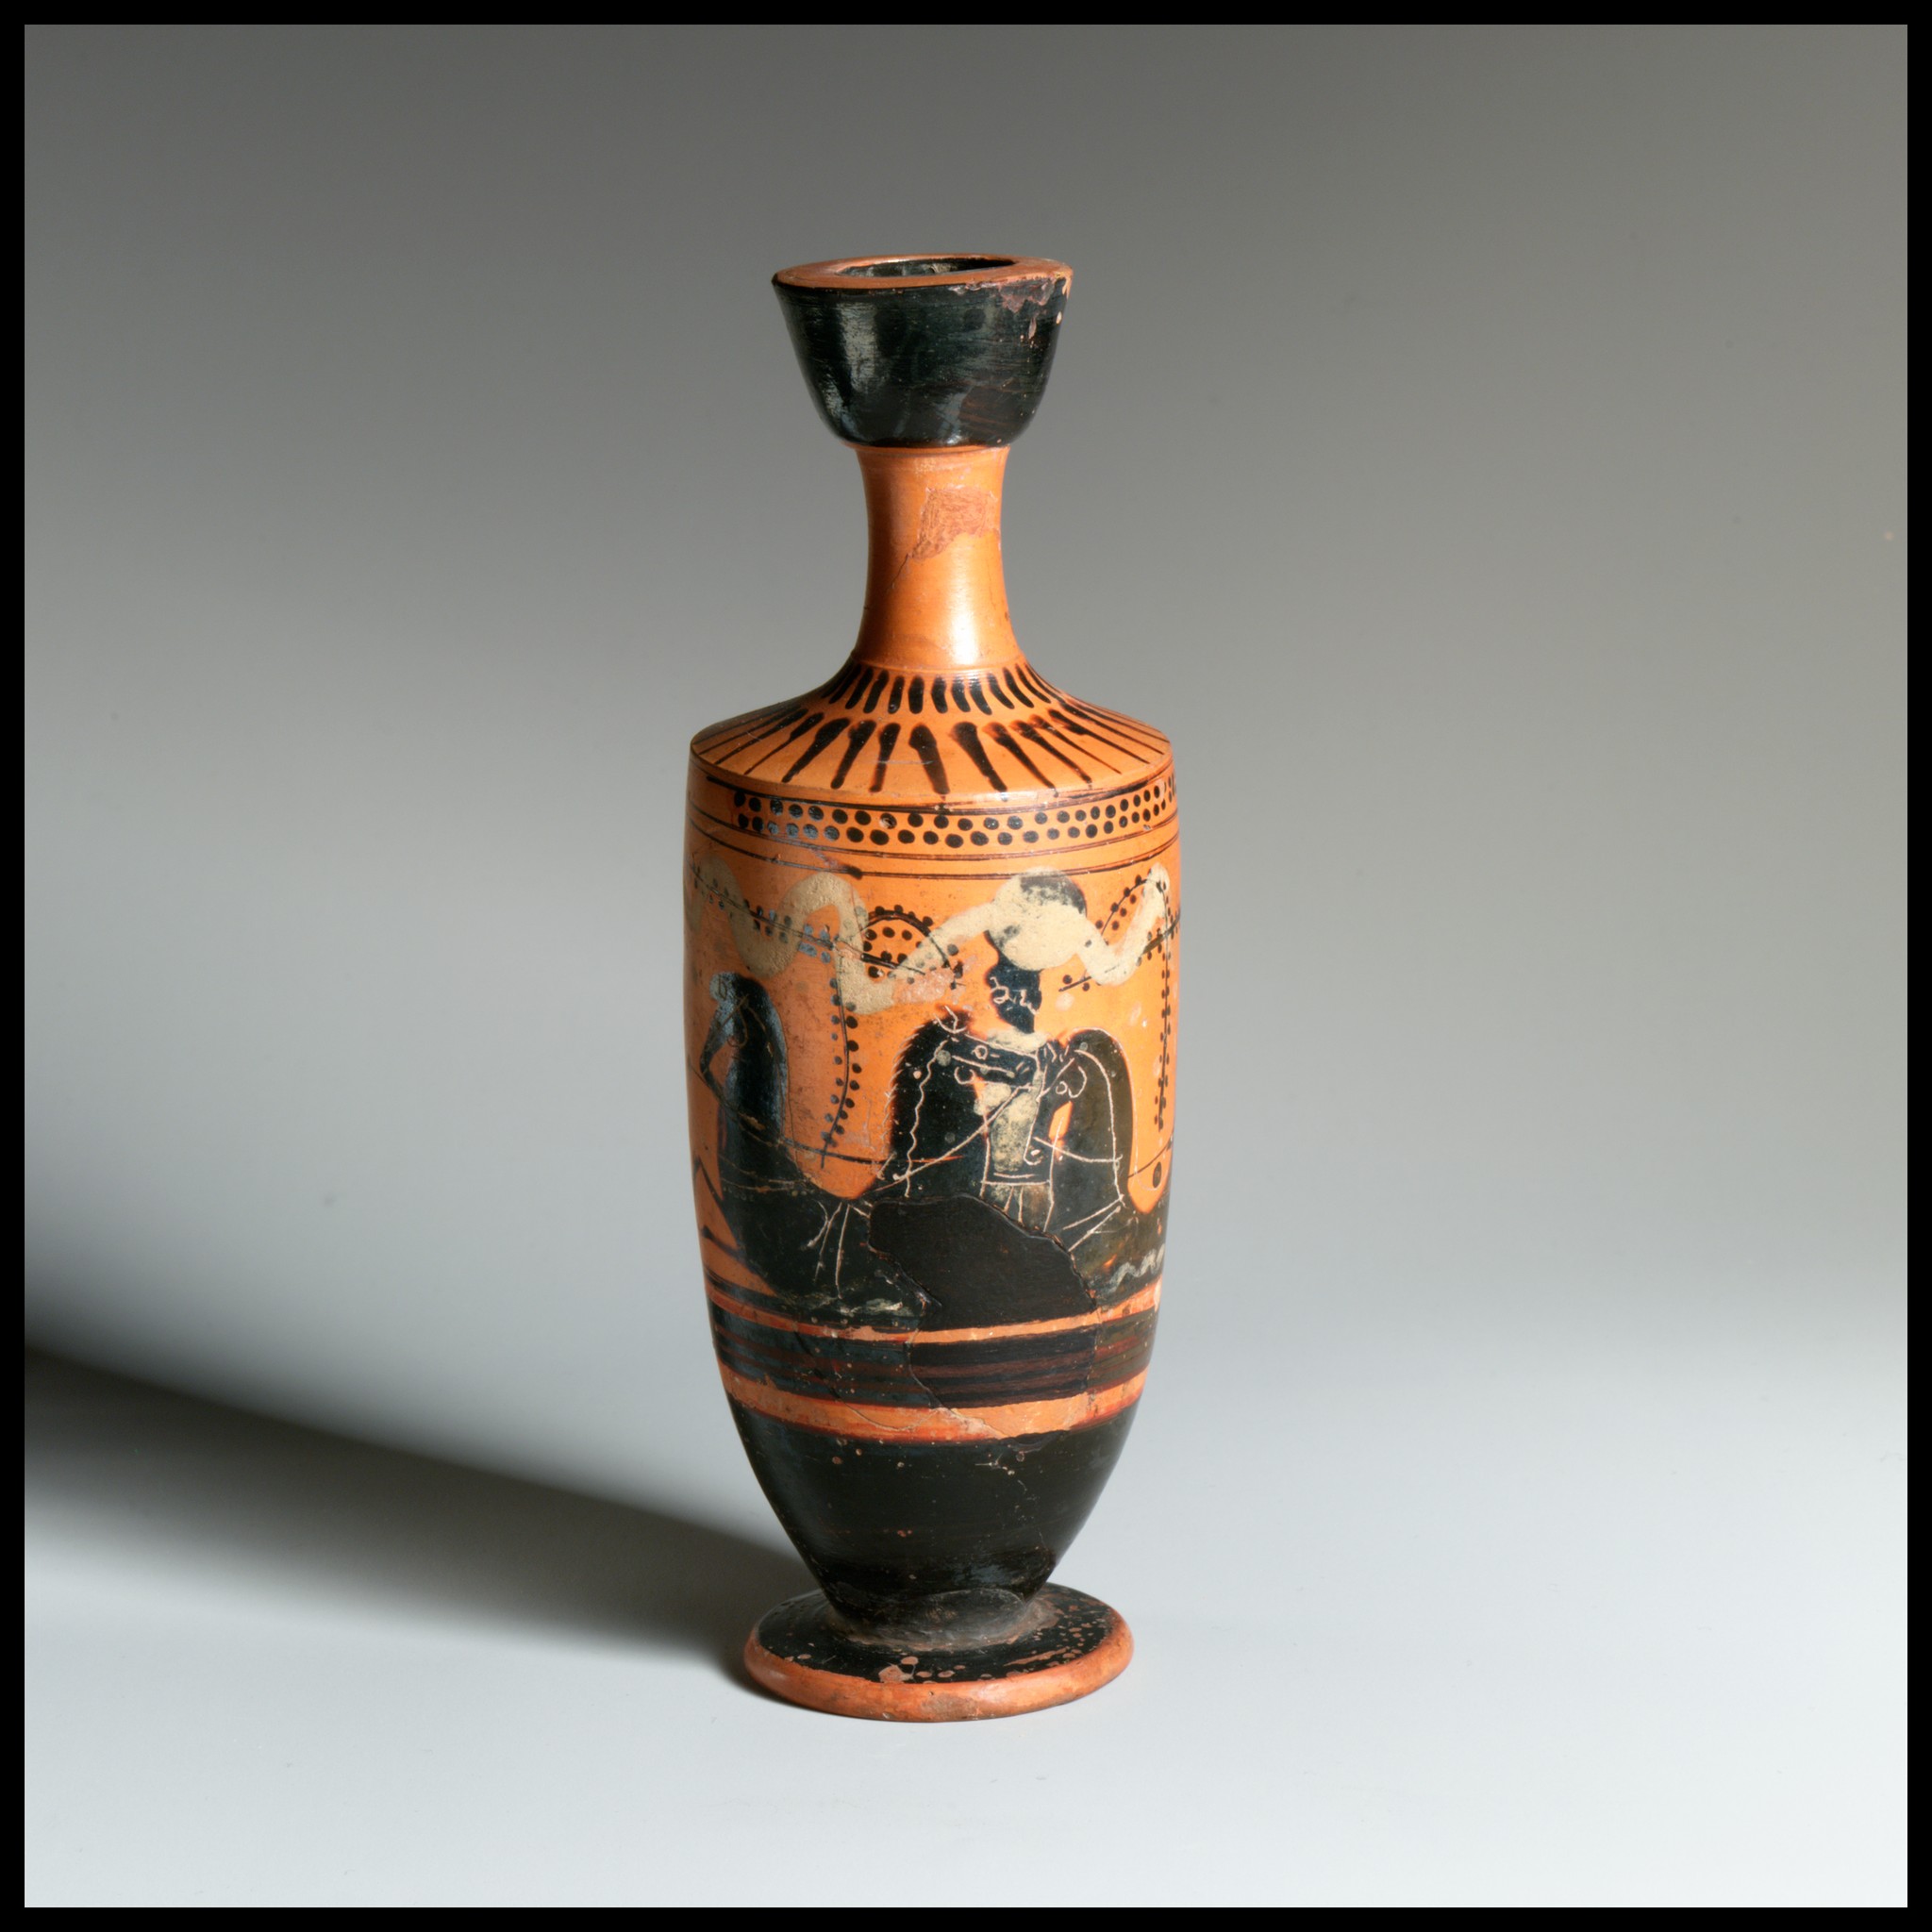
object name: lekythos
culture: greek, attic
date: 500-476 BCE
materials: terracotta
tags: horses